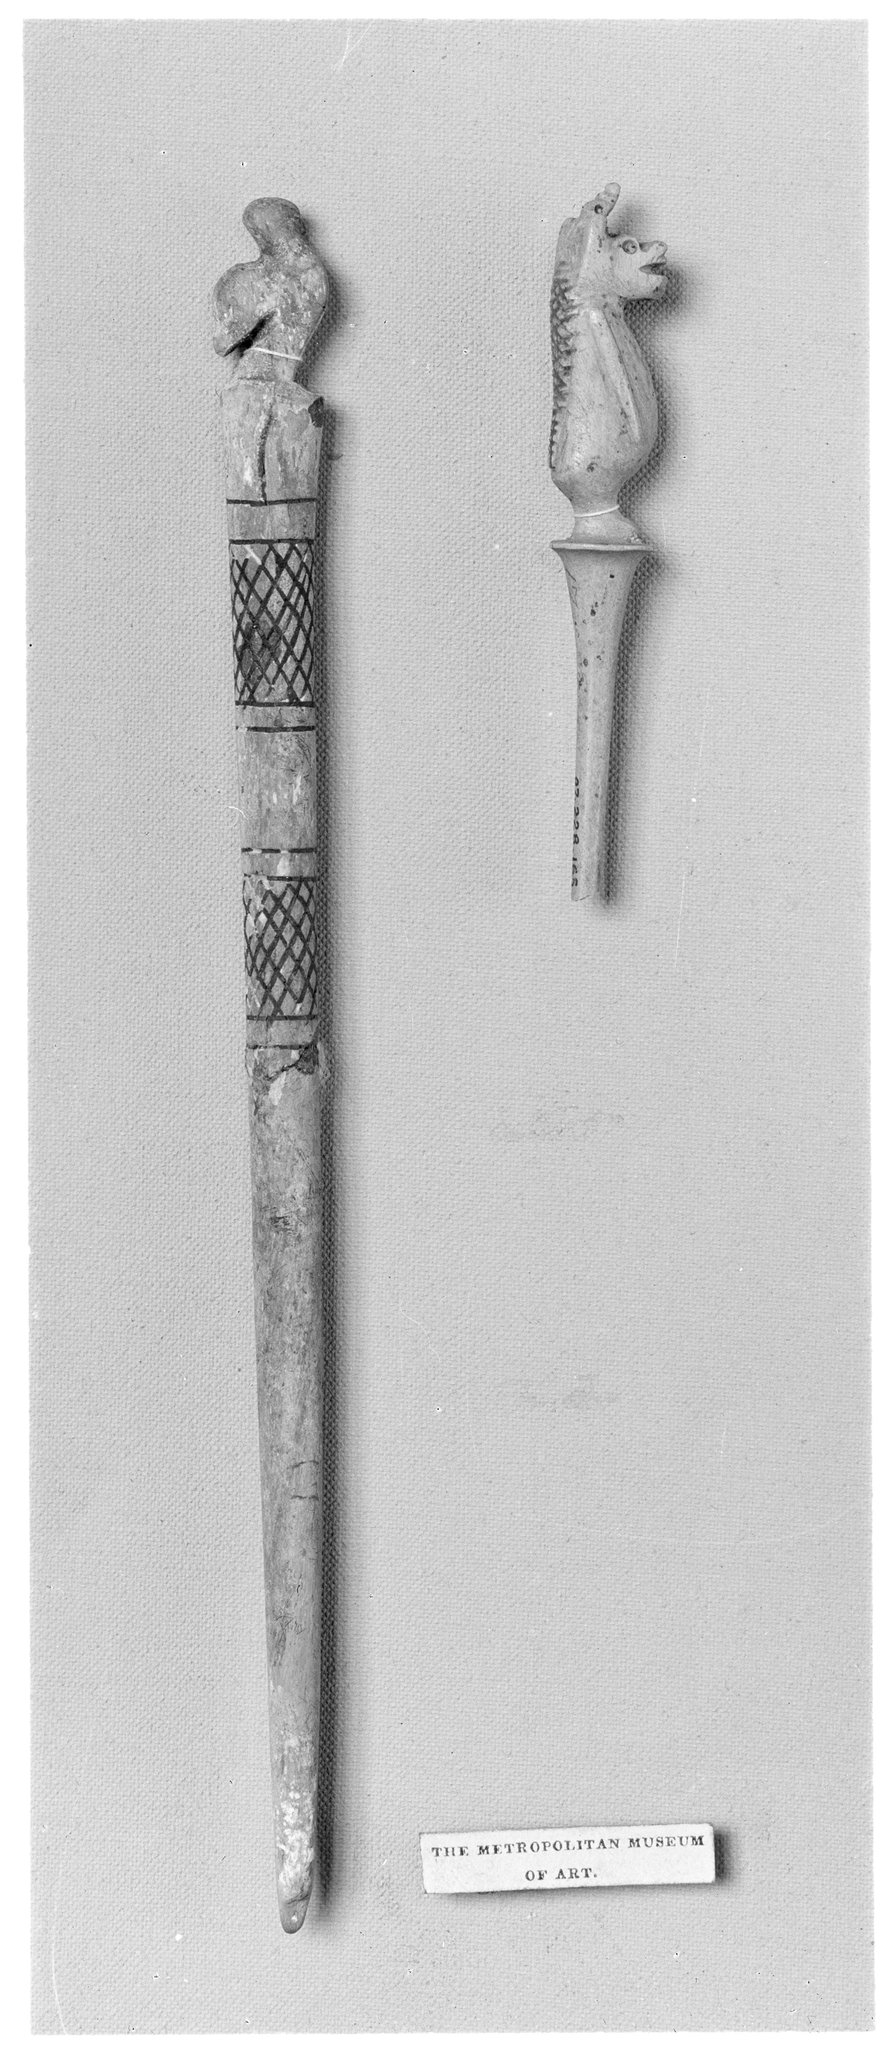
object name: cosmetic pin, bird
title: Pin topped with a bird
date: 3900-3500 BCE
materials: bone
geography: egypt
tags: birds,horses